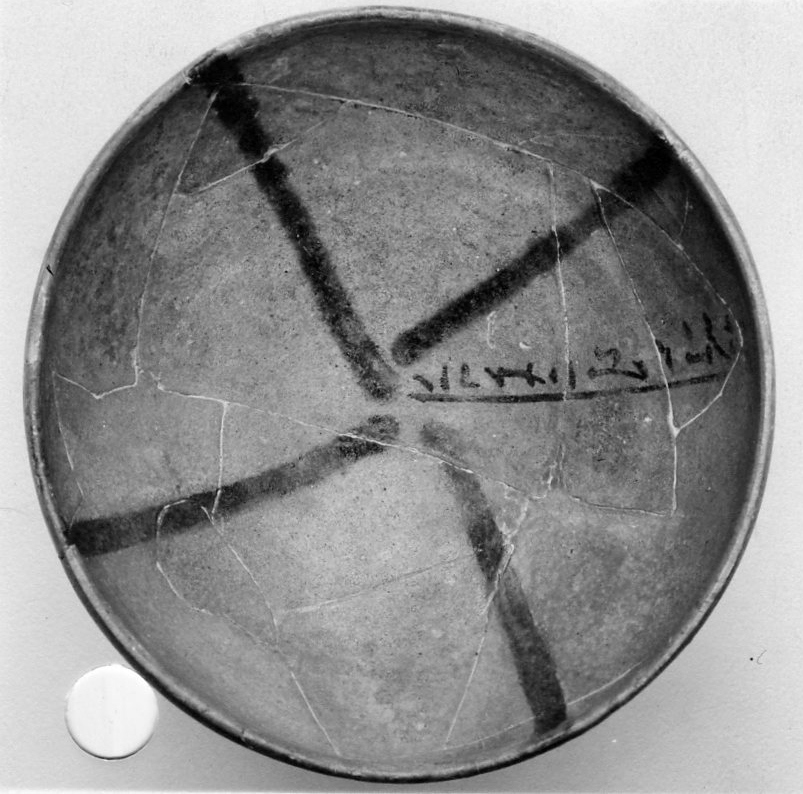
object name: bowl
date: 801-1000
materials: earthenware, glaze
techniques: polychrome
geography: iran